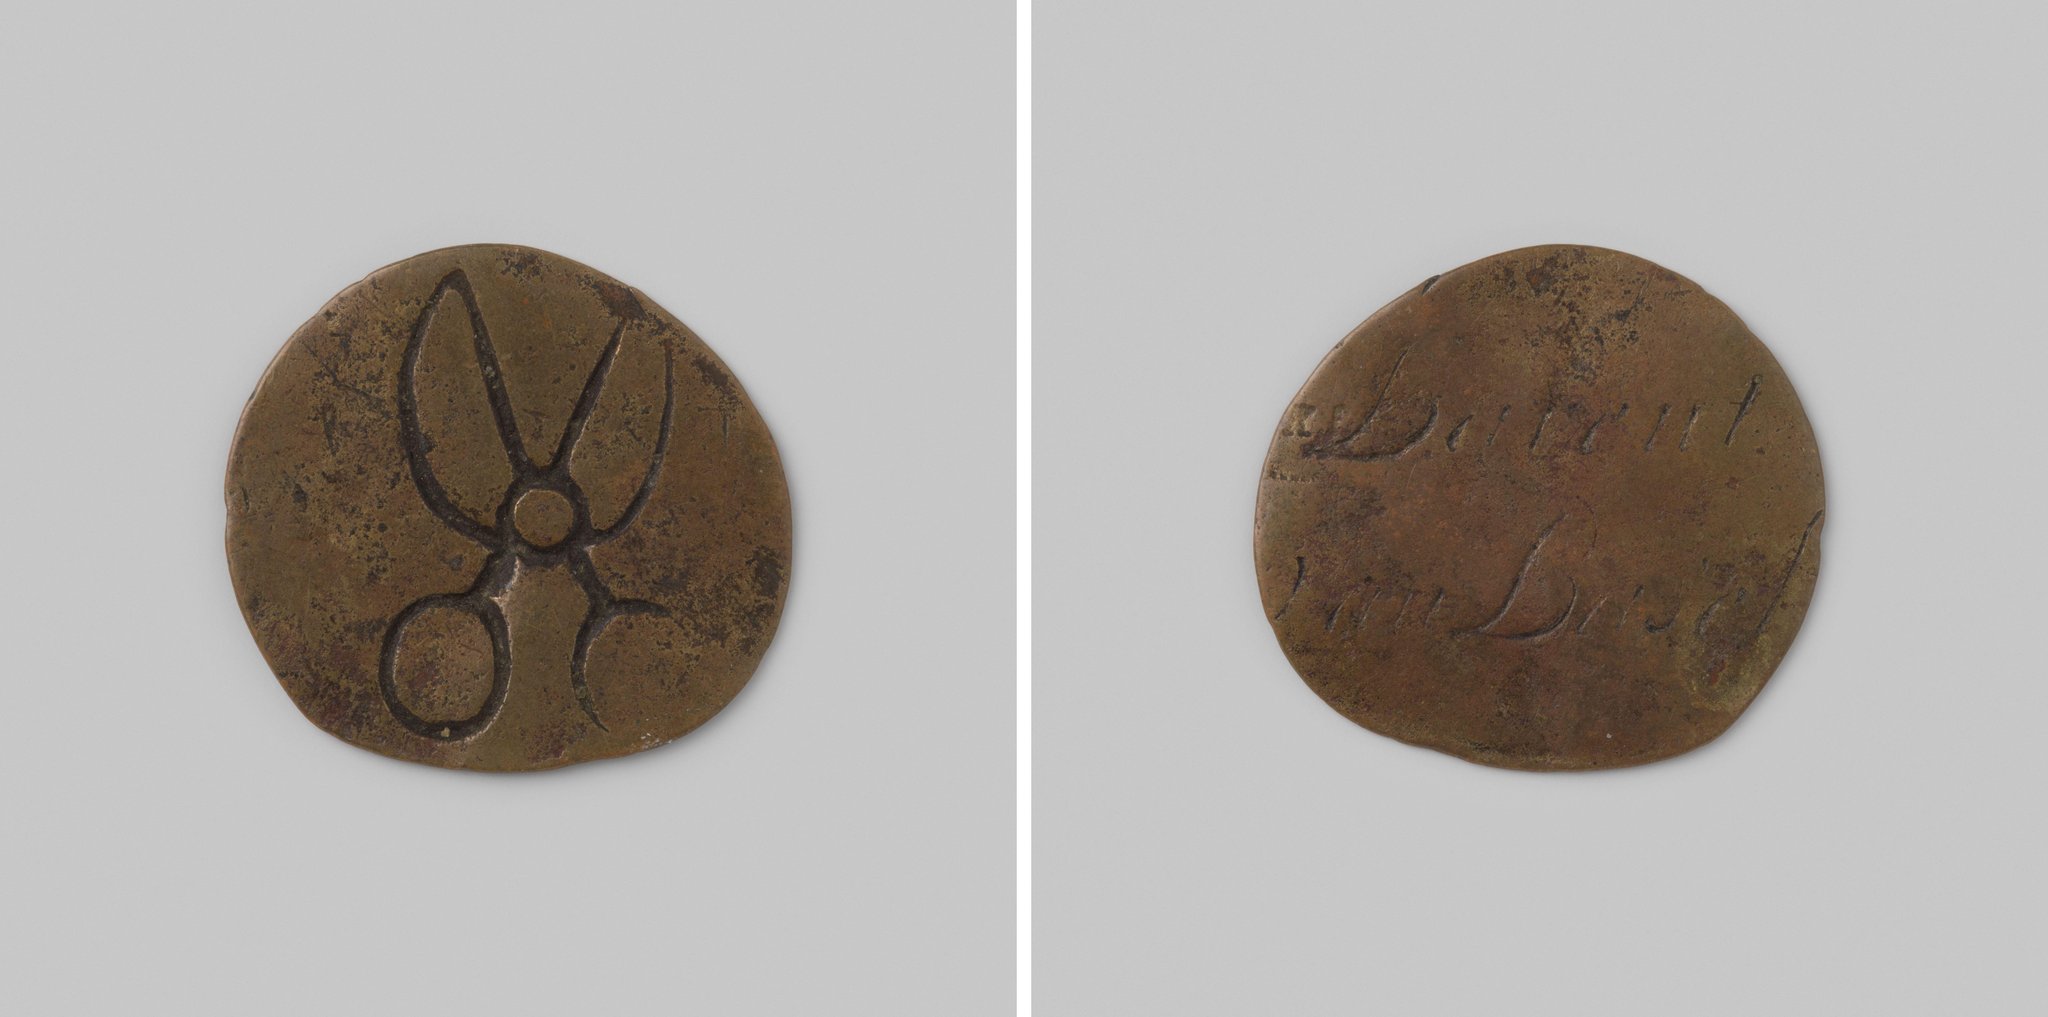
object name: medal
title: Presentiepenning van het Kleermakersgilde te Amsterdam, 1710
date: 1600-1700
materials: brass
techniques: engraving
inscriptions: inscription: ‘Barent / van Basch (van Basel ?)’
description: Rond plaatje messing gegraveerd op de voorzijde schaar, op de keerzijde twee regels tekst, op naam van Barent van Basch